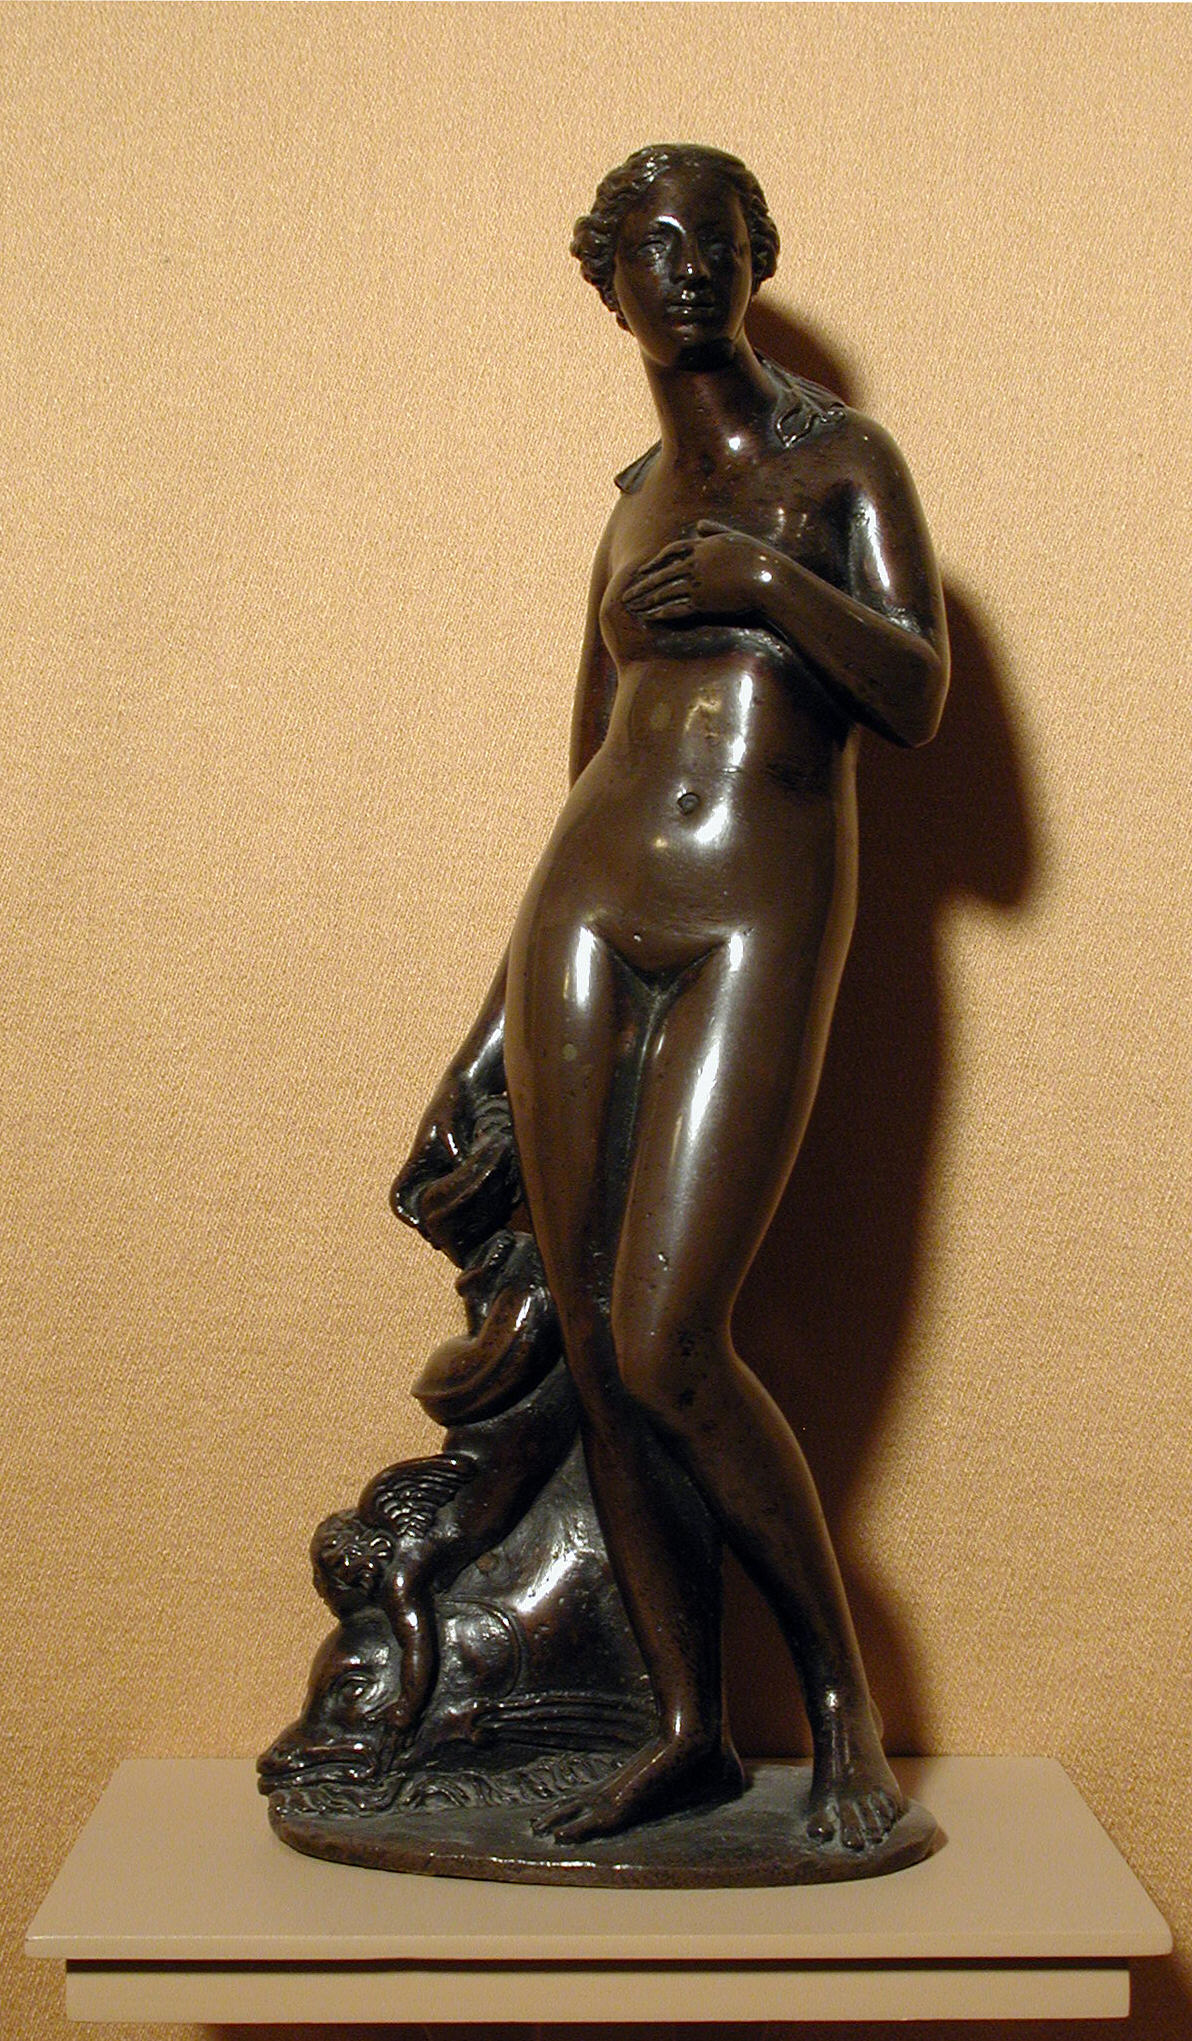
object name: statuette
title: Venus Anadyomene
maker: barthélemy prieur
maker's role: artist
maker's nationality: french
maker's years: 1536-1611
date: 1601-1633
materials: bronze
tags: female nudes,venus